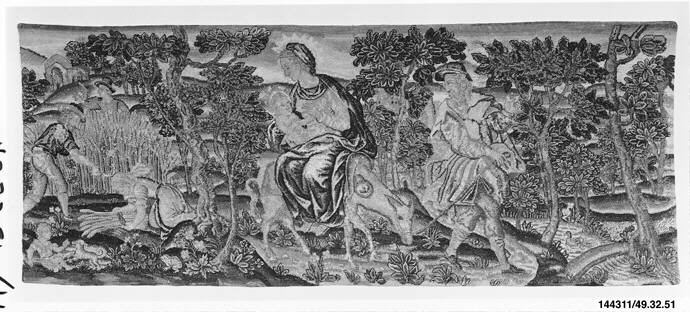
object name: panel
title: The Flight into Egypt (one of a set of four)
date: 1601-1633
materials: canvas, wool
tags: infants,men,women,donkeys,working